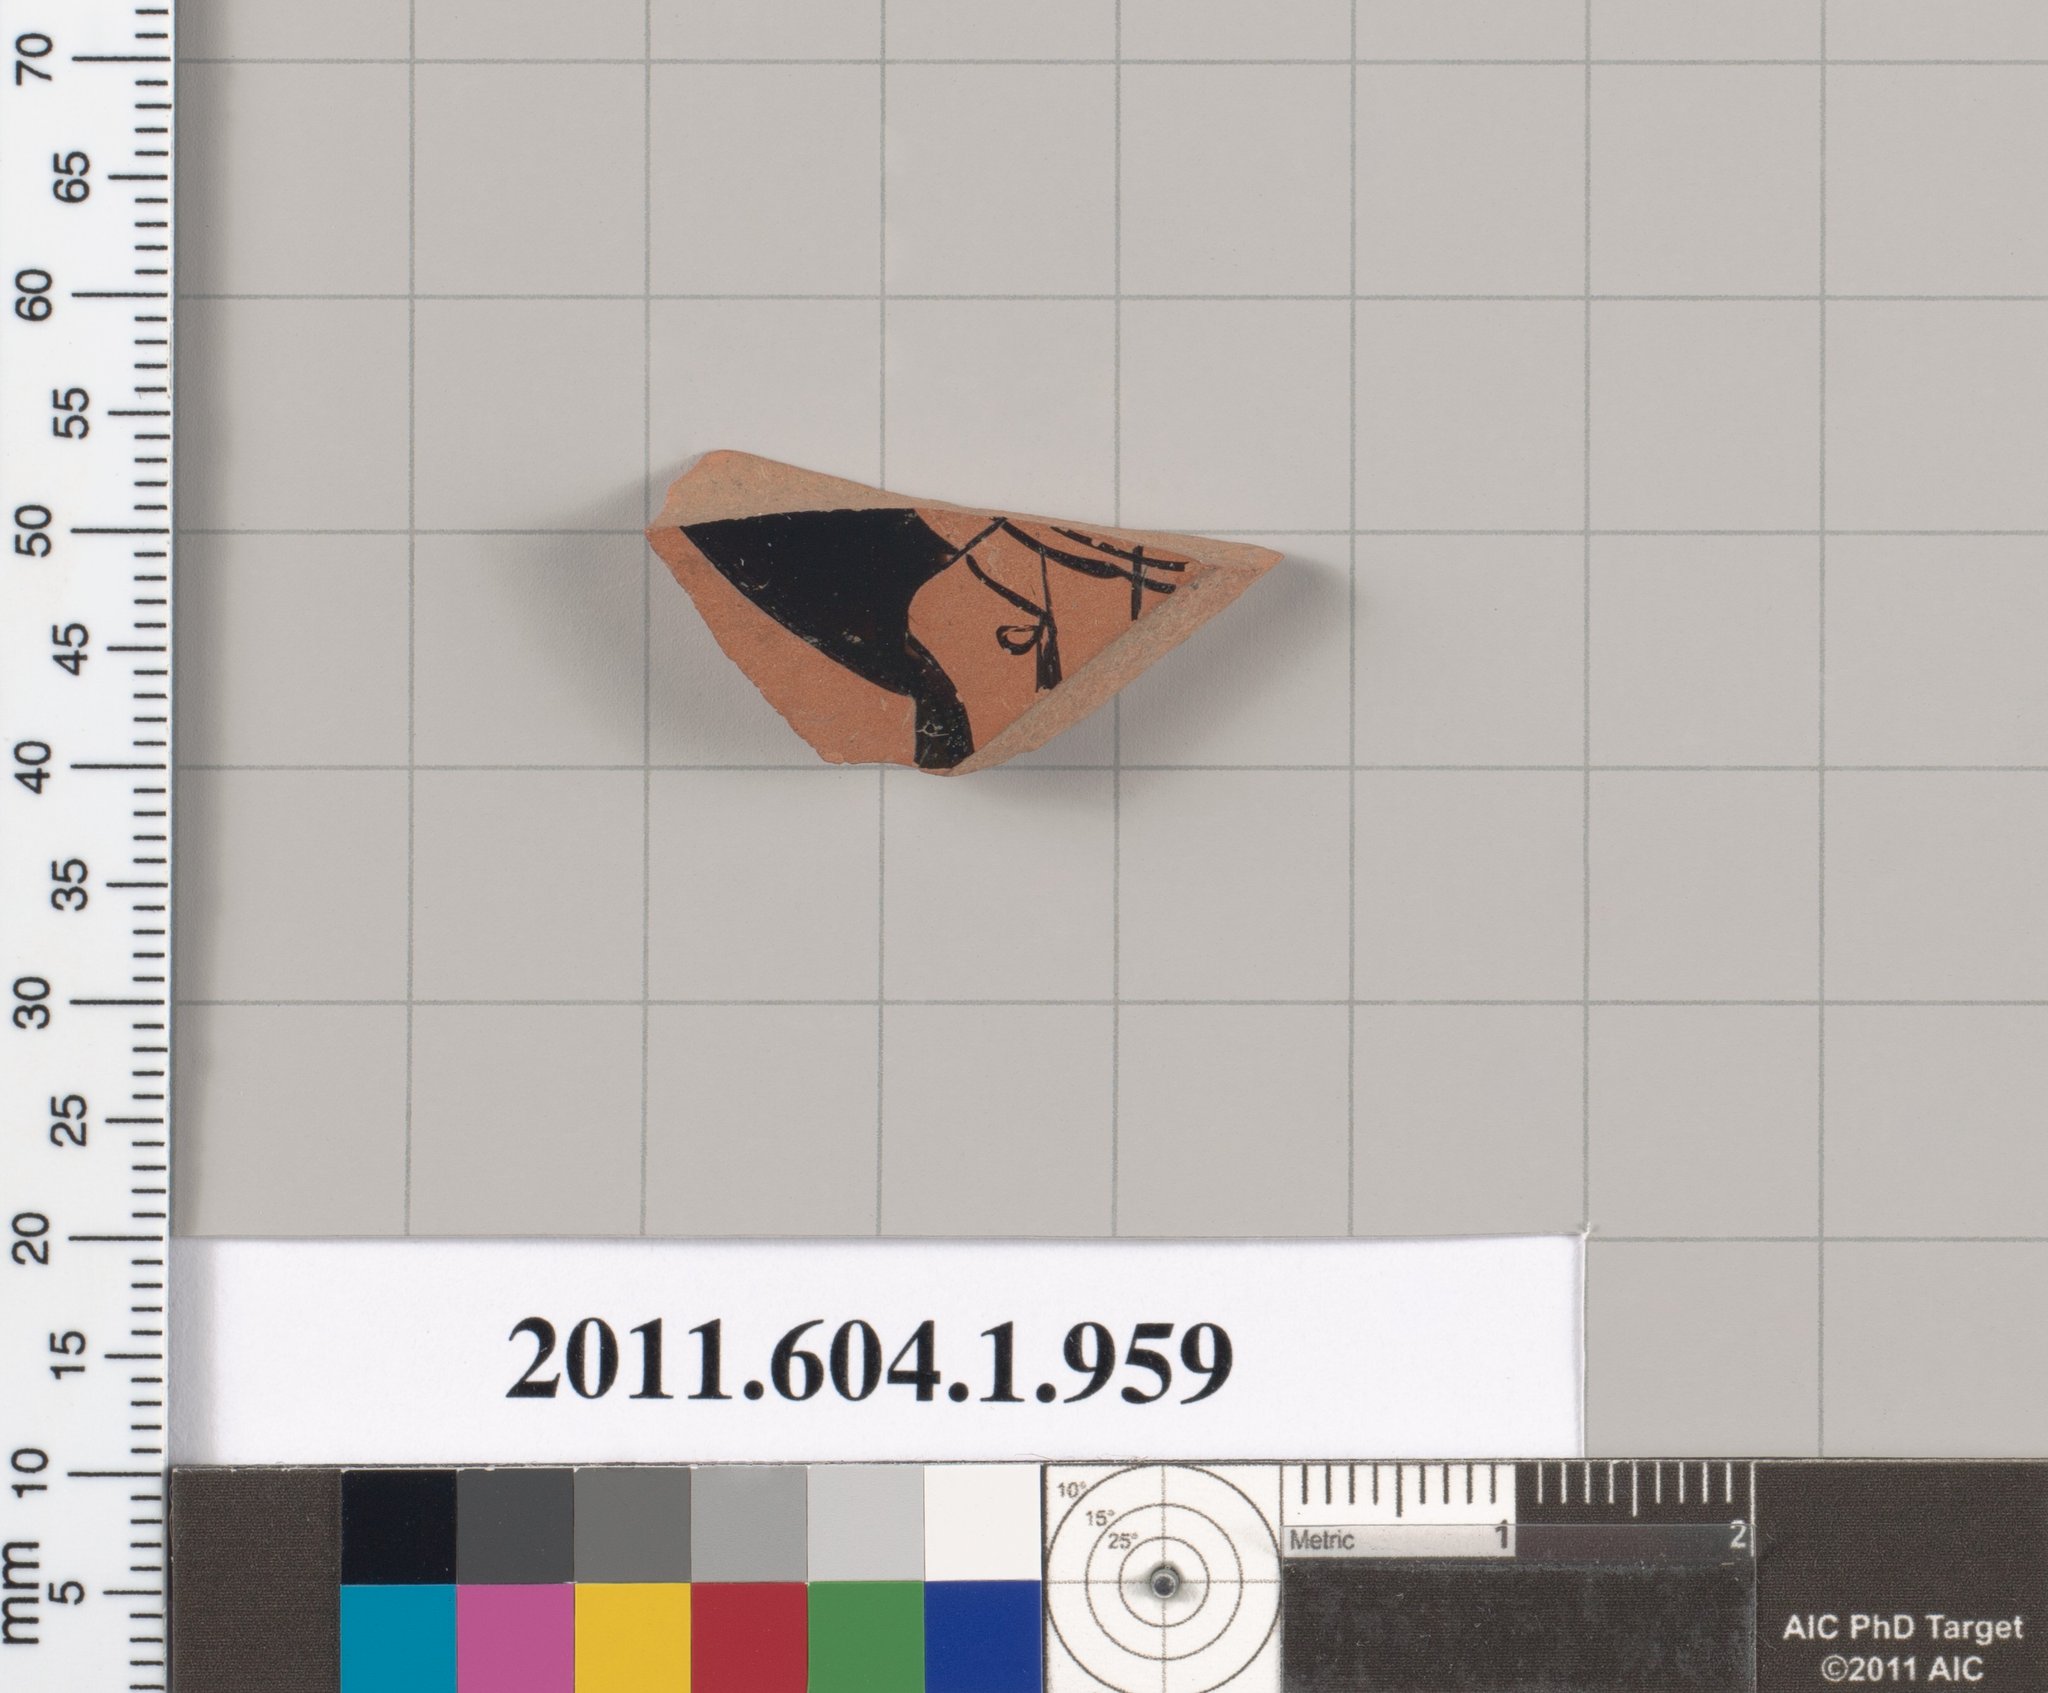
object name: kylix fragment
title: Terracotta fragment of a kylix (drinking cup)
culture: greek, attic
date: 490-480 BCE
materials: terracotta